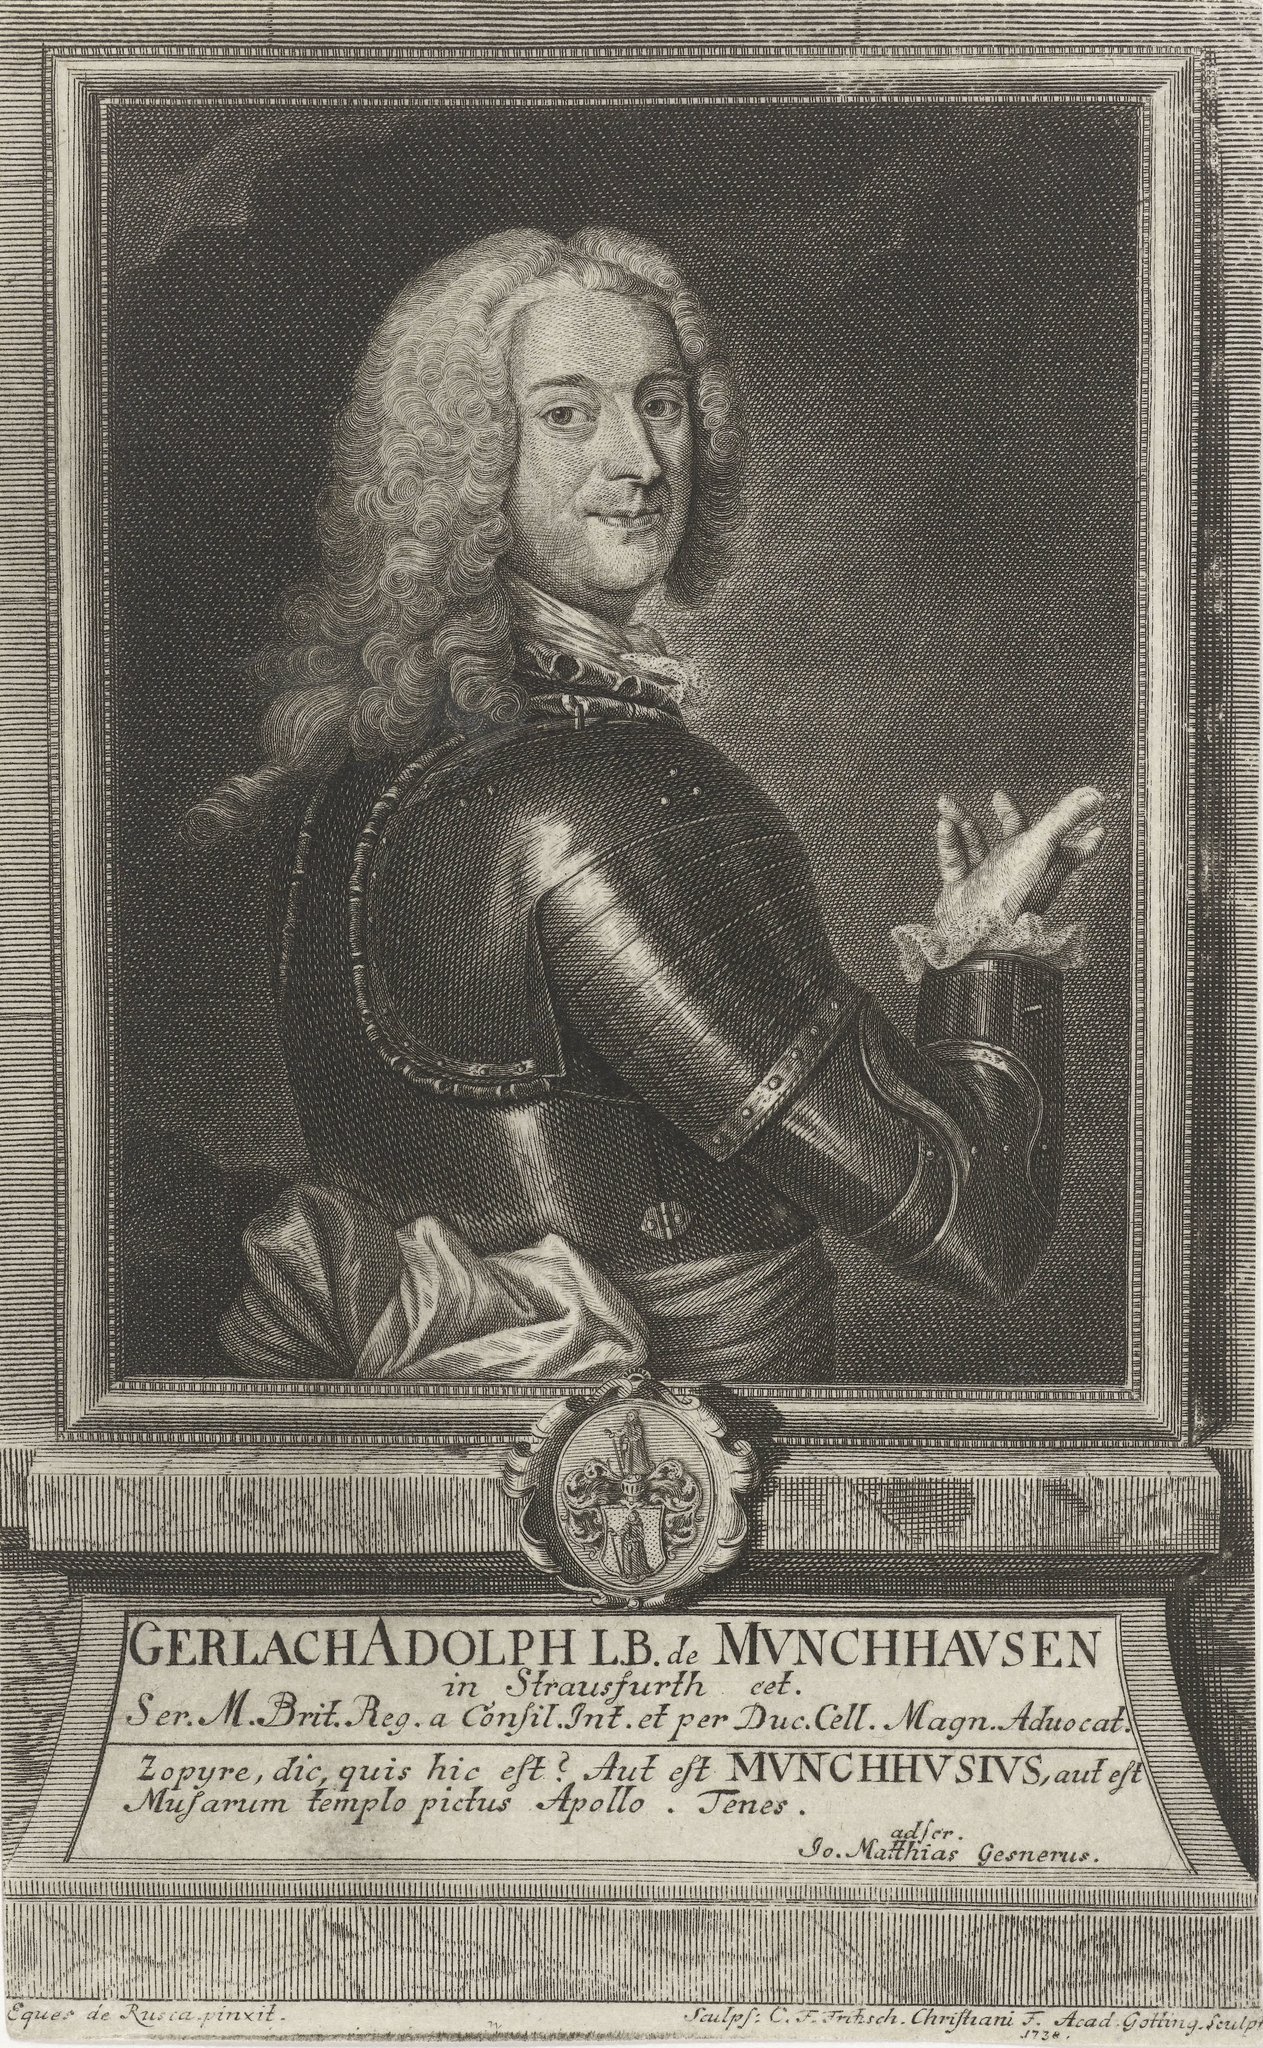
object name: print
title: Portret van Gerlach Adolph van Münchhausen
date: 1738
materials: paper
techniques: engraving, etching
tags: berlin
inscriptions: collector's mark: Lugt 2228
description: Portret van Gerlach Adolph van Münchhausen, ten halven lijve naar rechts, in harnas. Onder het ovaal staan op een sokkel zijn naam en titel vermeld, hieronder een tweeregelige tekst in het Latijn. Op de sokkellijst prijkt een cartouche met een gehelmd wapenschild.